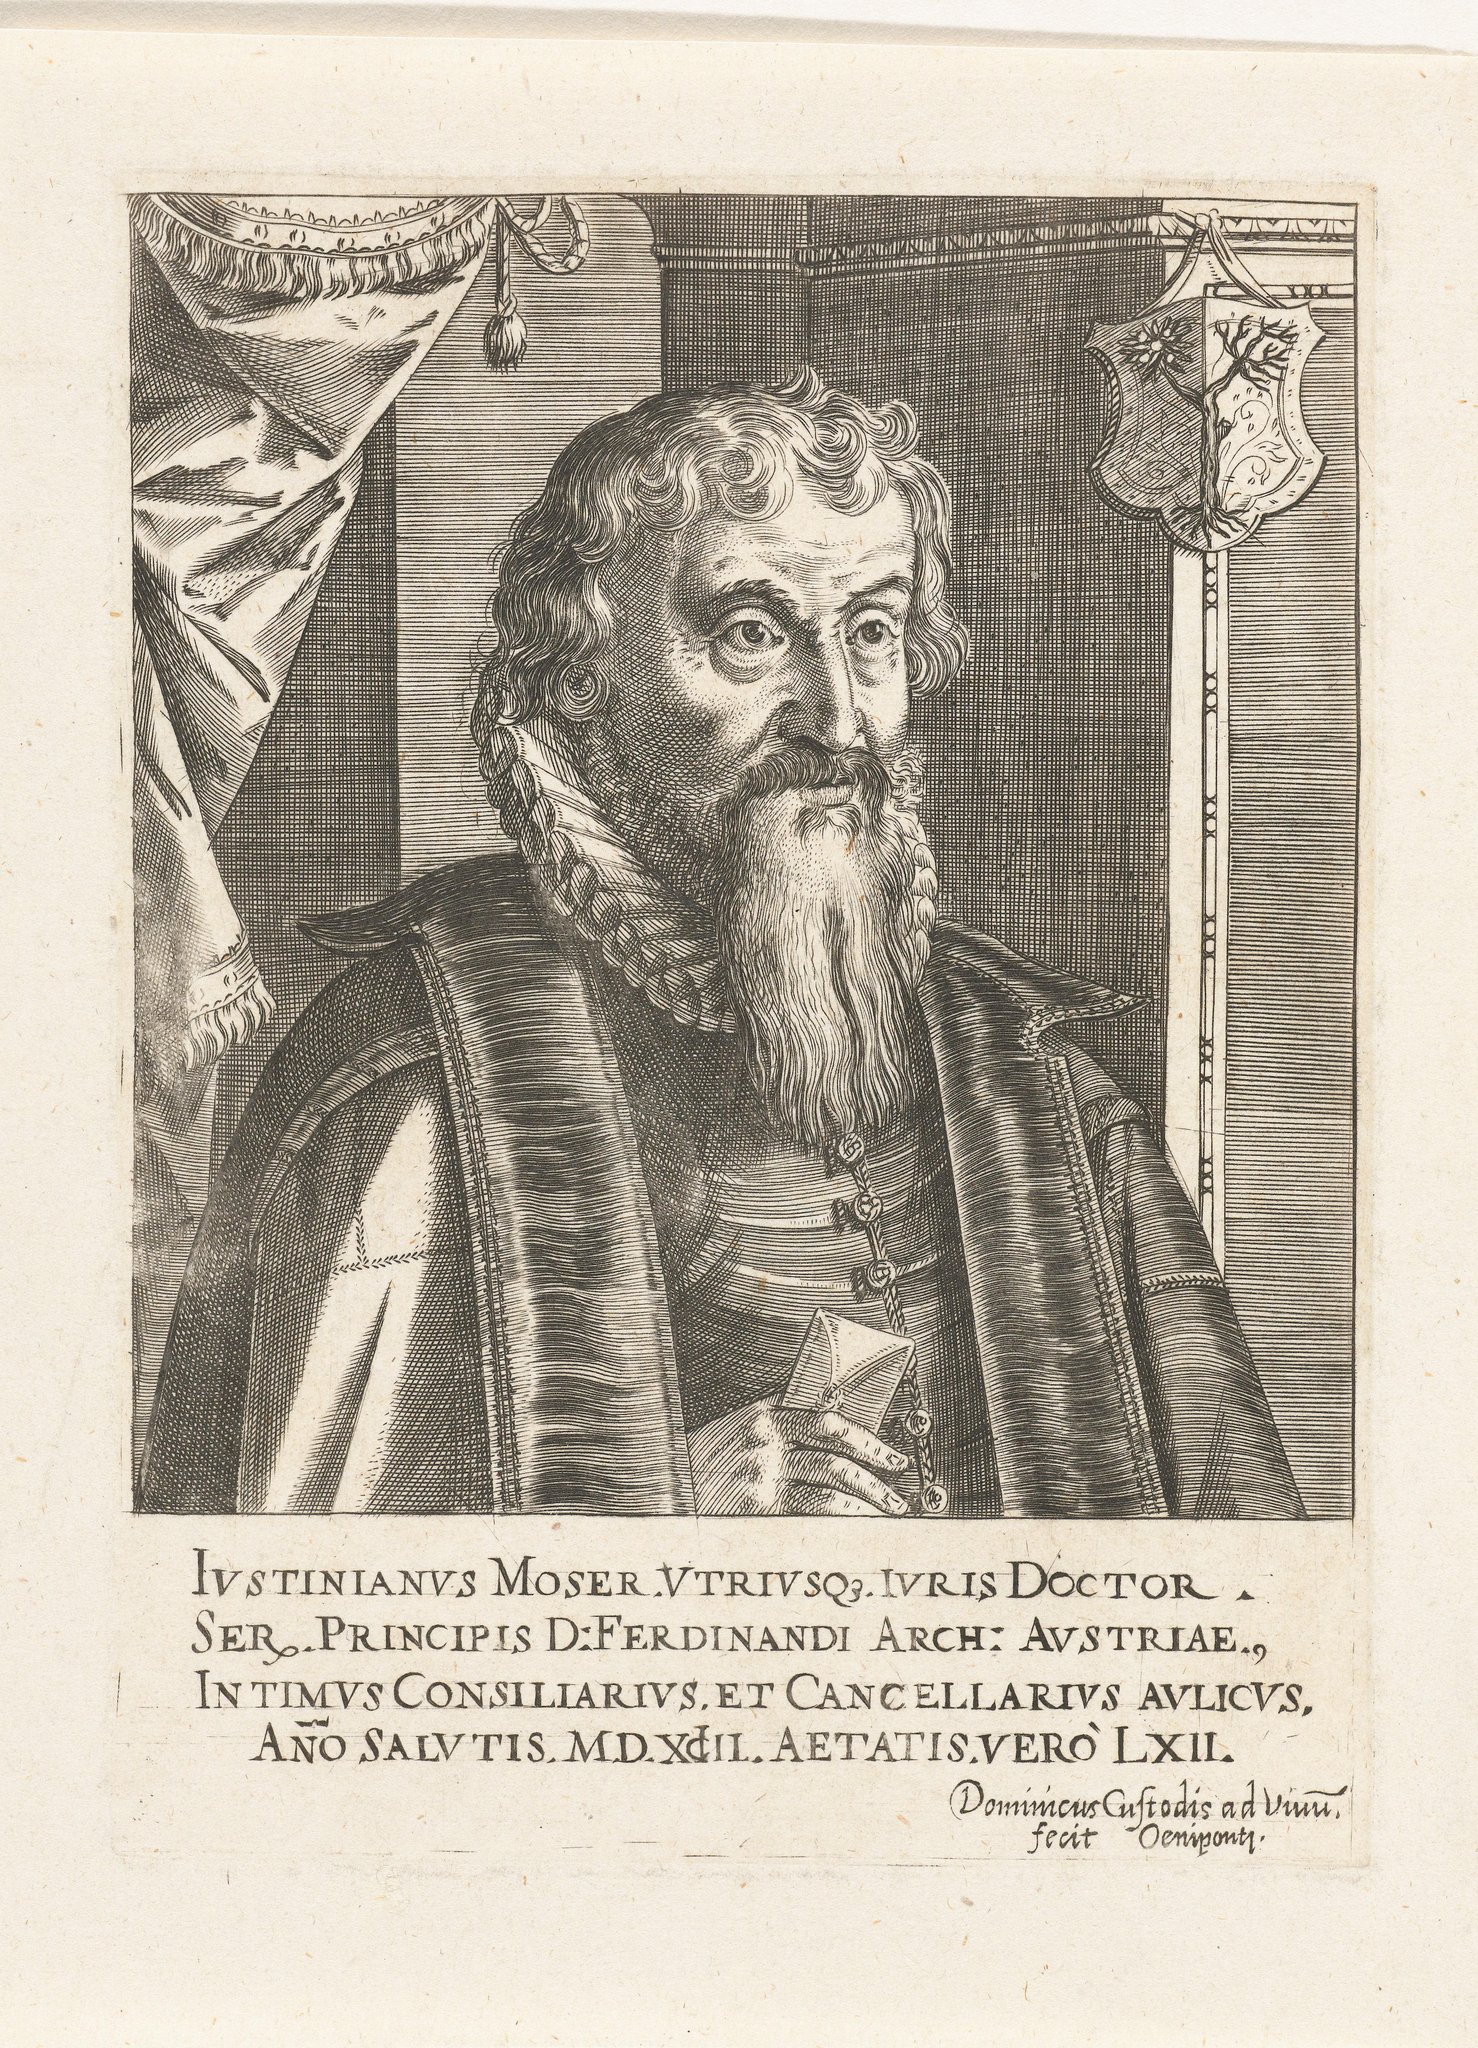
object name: print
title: Portret van de jurist Justinianus Moser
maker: dominicus custos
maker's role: print maker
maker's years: 1560-1615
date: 1615-1679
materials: paper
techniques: engraving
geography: innsbruck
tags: jurist, justinianus moser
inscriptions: collector's mark: Lugt 2228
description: Portret van de jurist Justinianus Moser op 62-jarige leeftijd, met brief in zijn hand. Rechts het familiewapen, onder het portret zijn naam en titels.